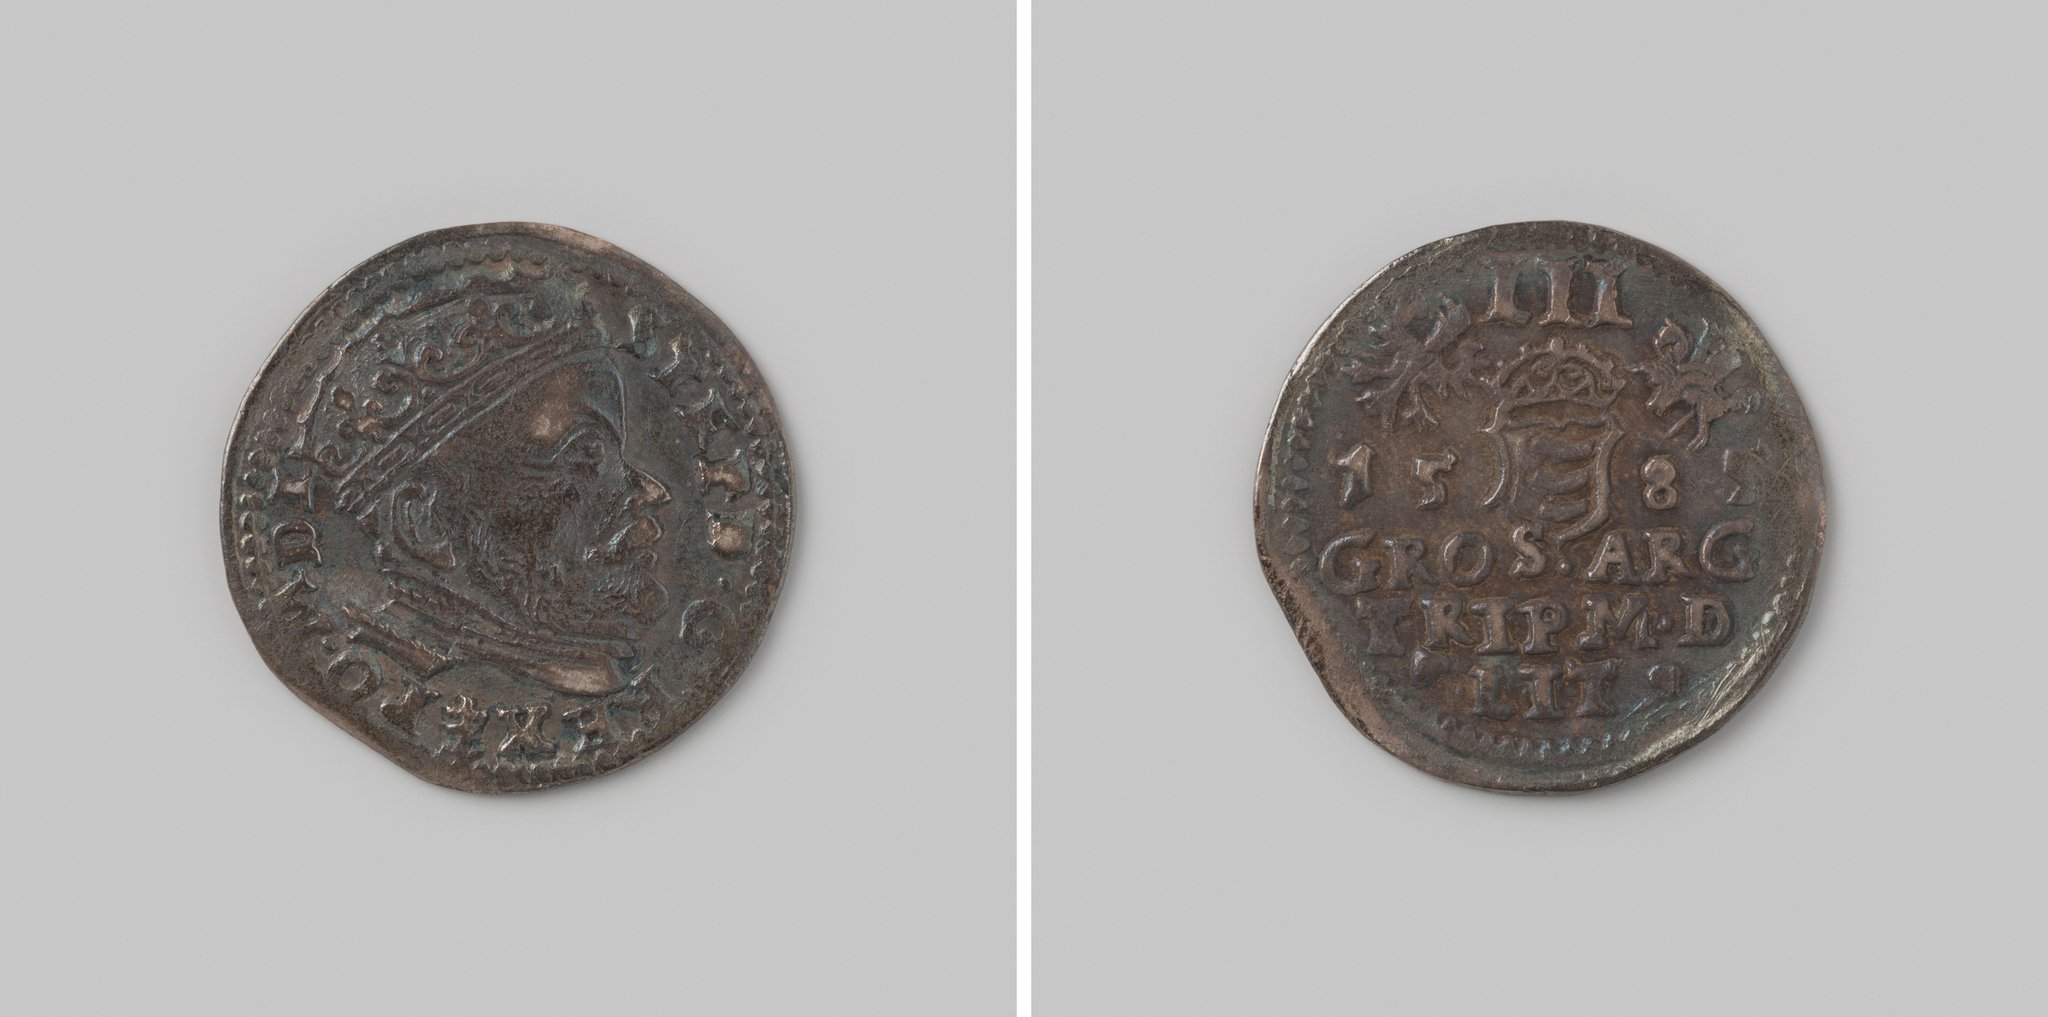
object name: coin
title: Litauen, Stefan Batory van Polen, 3 groszii,1585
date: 1585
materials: silver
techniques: striking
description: Zilveren munt. Voorzijde: gekroond borstbeeld van de vorst naar rechts. Keerzijde: tussen jaartal gekroond wapenschild, links daarvan een arend, rechts een ridder te paard. Boven en ondr het wapenschild waarde-aanduiding in vier regels.